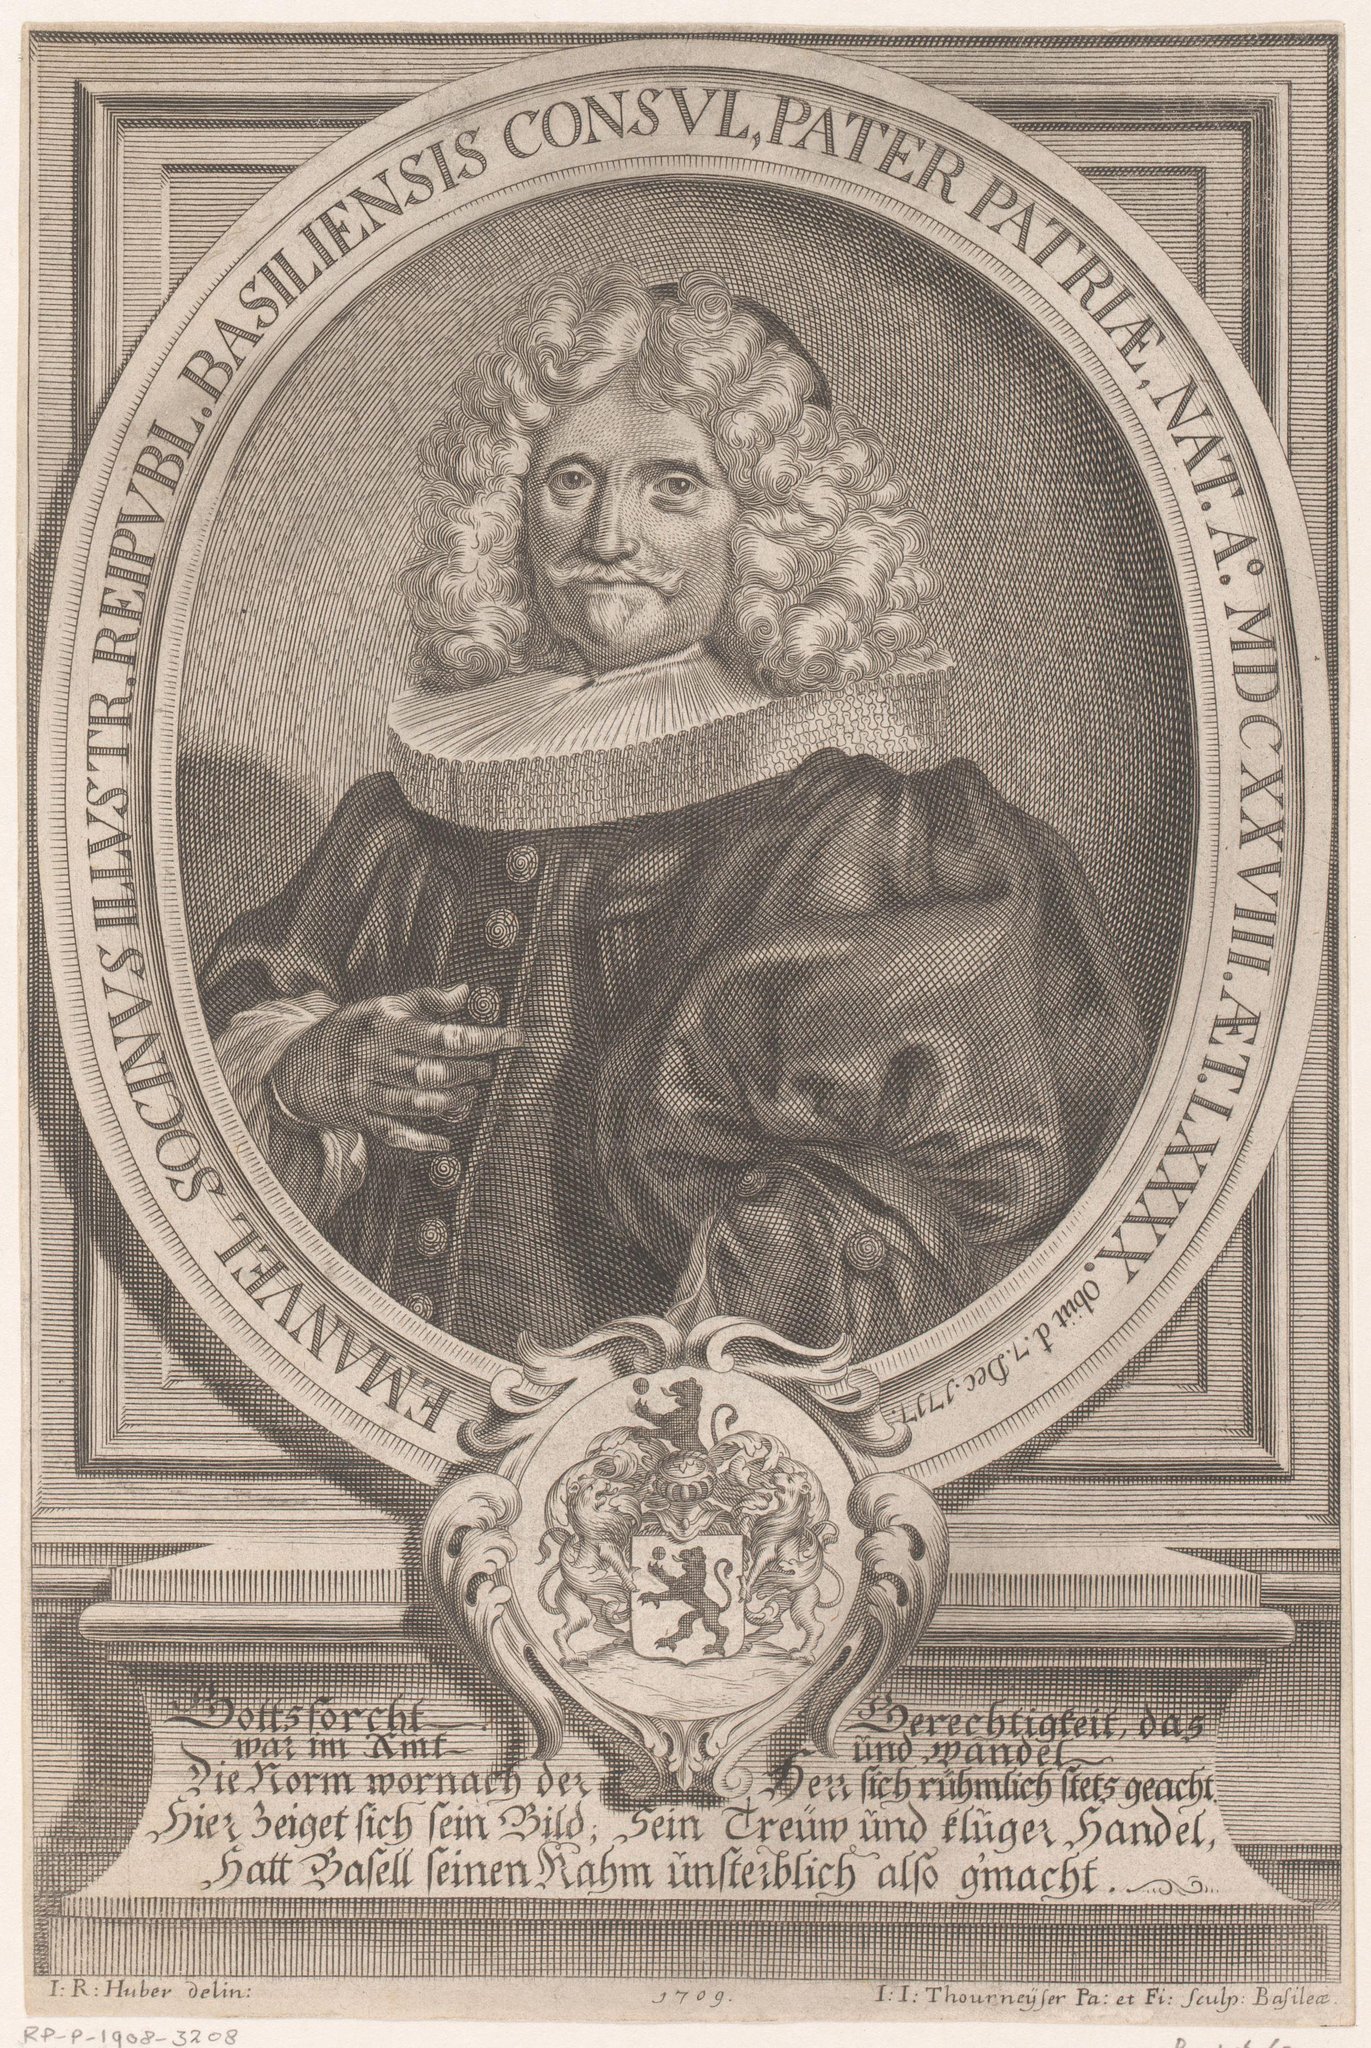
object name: print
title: Portret van Emanuel Socinus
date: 1709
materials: paper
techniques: engraving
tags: mayor, historical persons, armorial bearing, heraldry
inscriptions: collector's mark: Lugt 2228